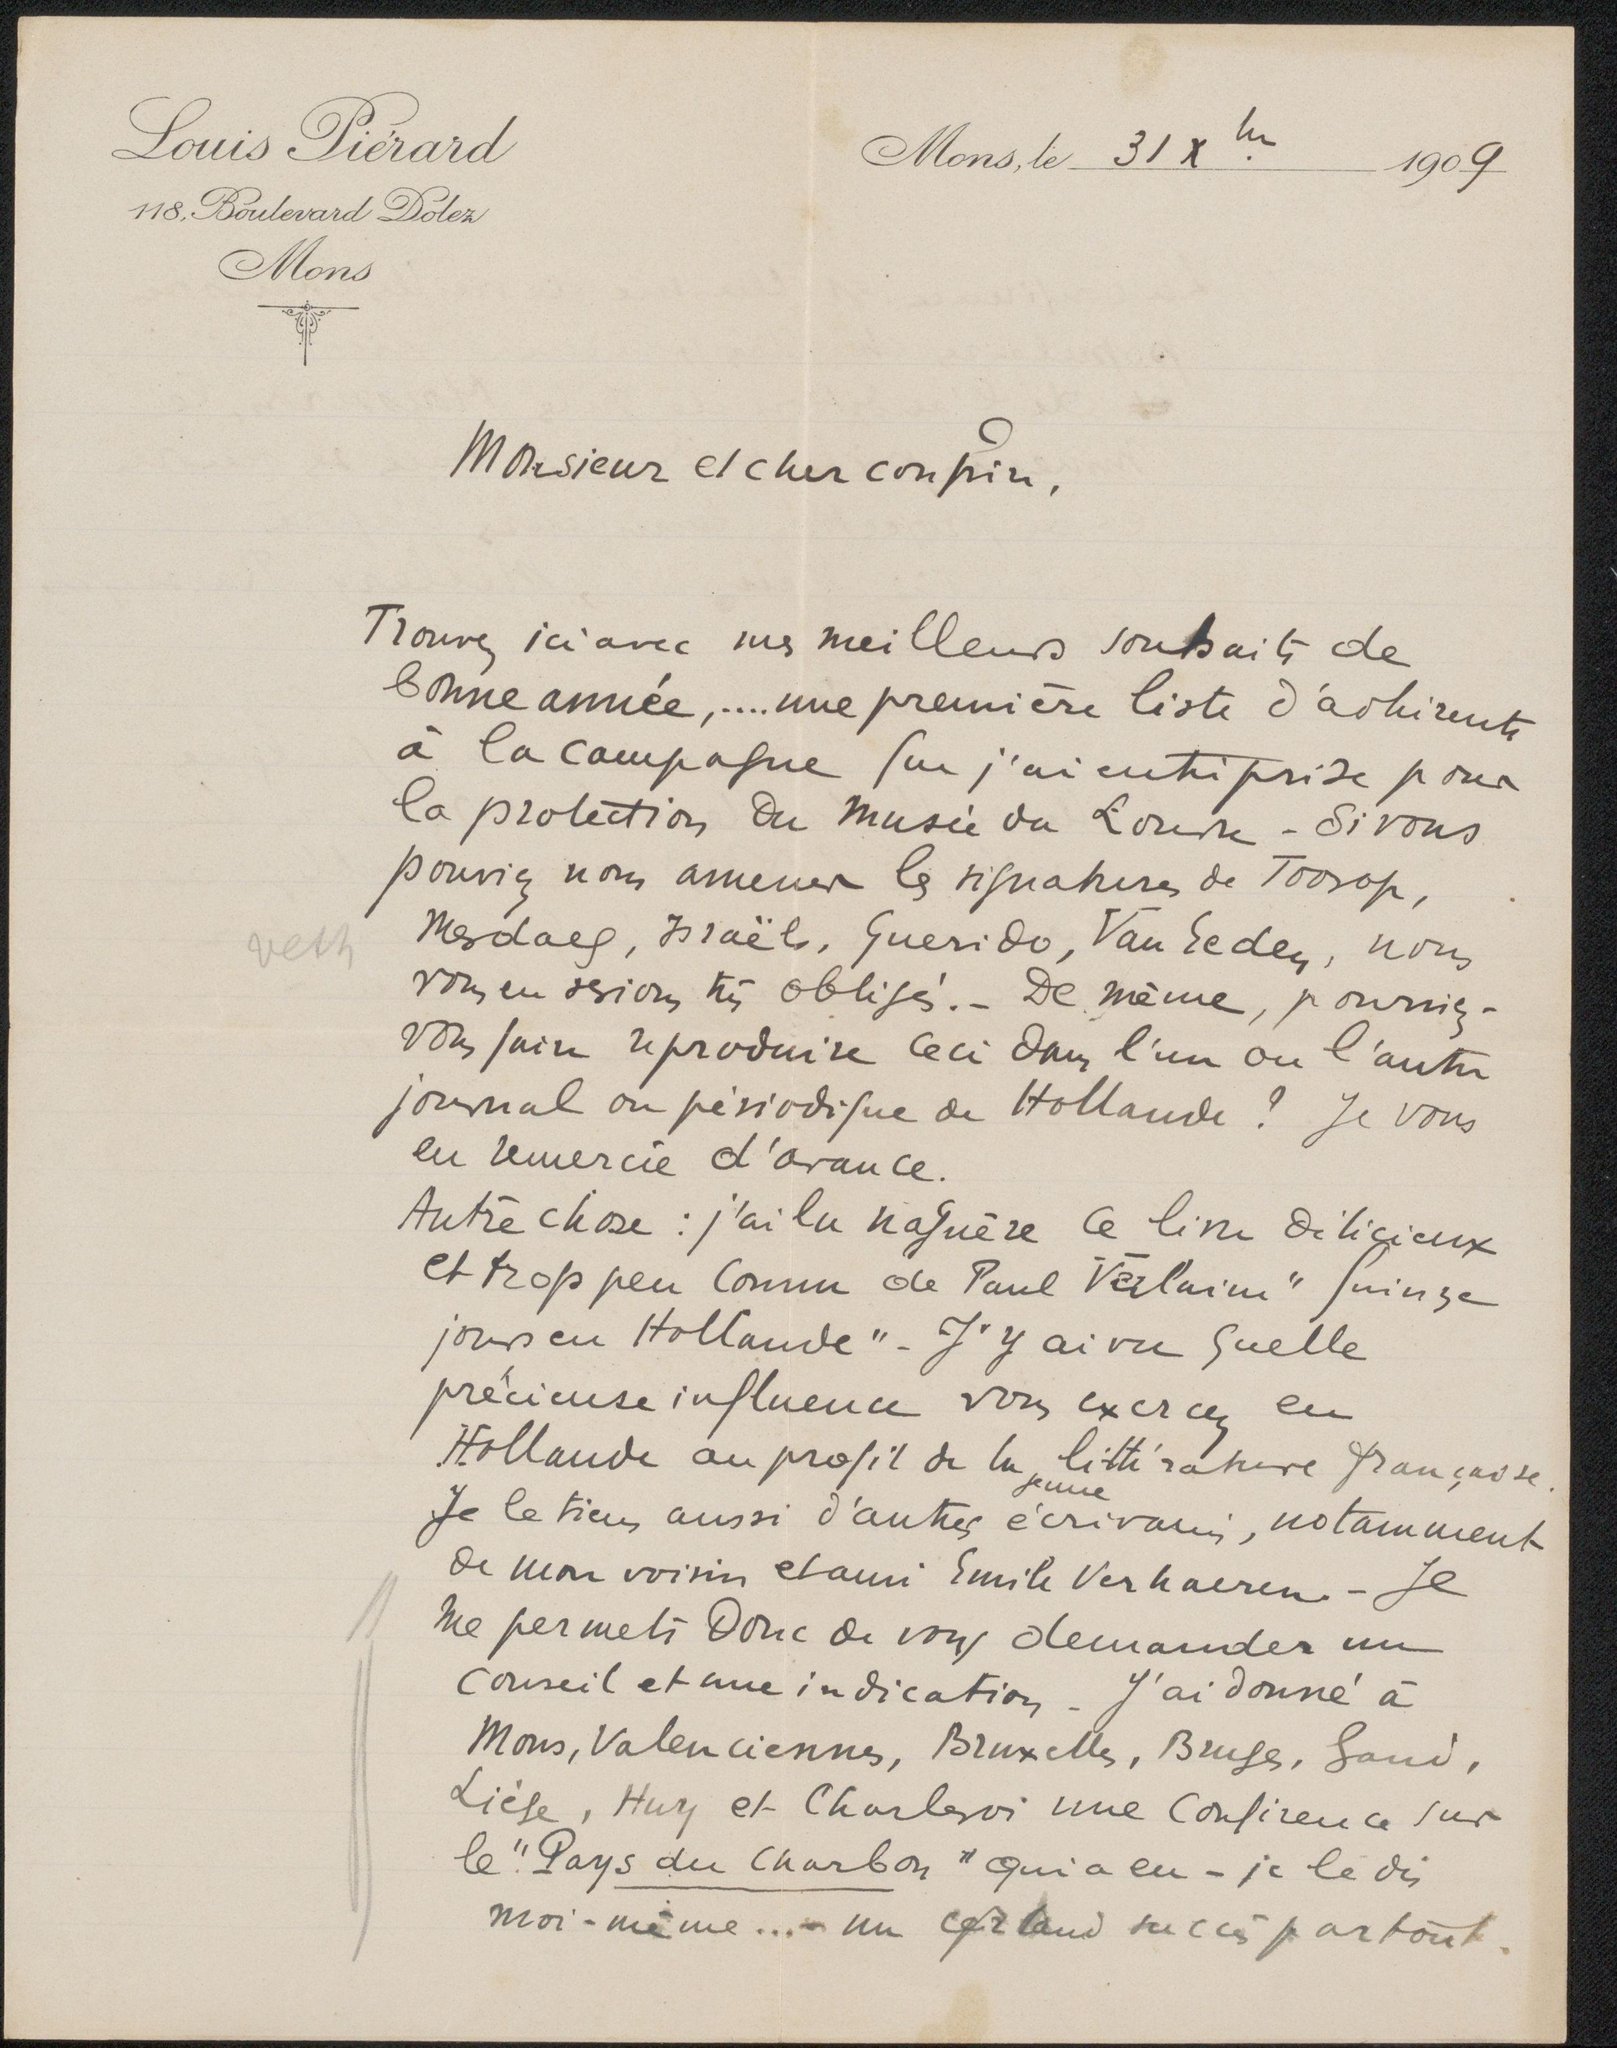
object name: letter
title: Brief aan Philip Zilcken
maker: louis piérard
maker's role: letterkundige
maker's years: 1886-1951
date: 1909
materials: ink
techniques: pen, printing, writing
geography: bergen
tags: the hague, painter, print maker, draughtsman, jozef israëls, hendrik willem mesdag, jan toorop, paul verlaine, haarlem, frederik van eeden, emile verhaeren, philip zilcken, literature ~ arts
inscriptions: collector's mark: ‘RPK’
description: Brief bevat oproep 'Pour la protection du Louvre'.